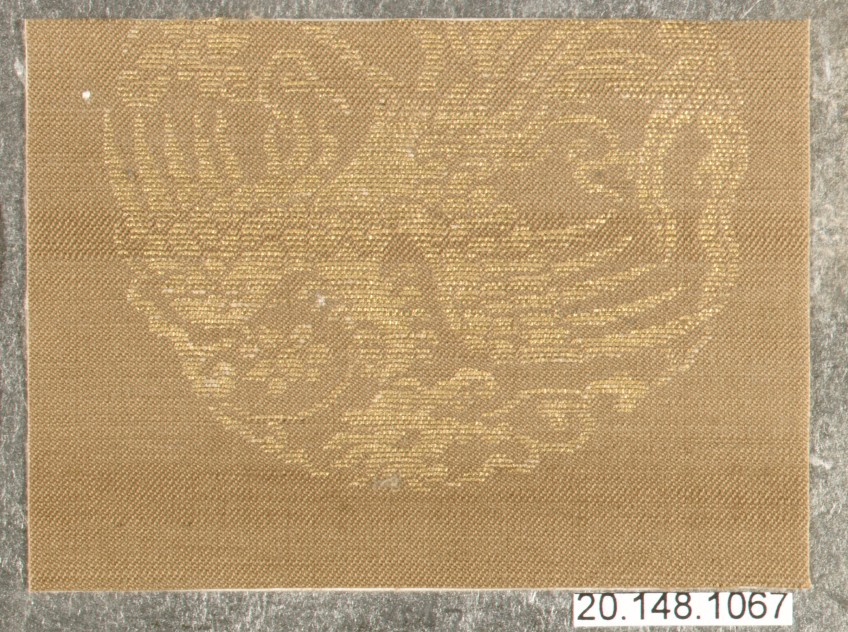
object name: piece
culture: chinese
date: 1701-1800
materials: silk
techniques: compound weave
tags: birds